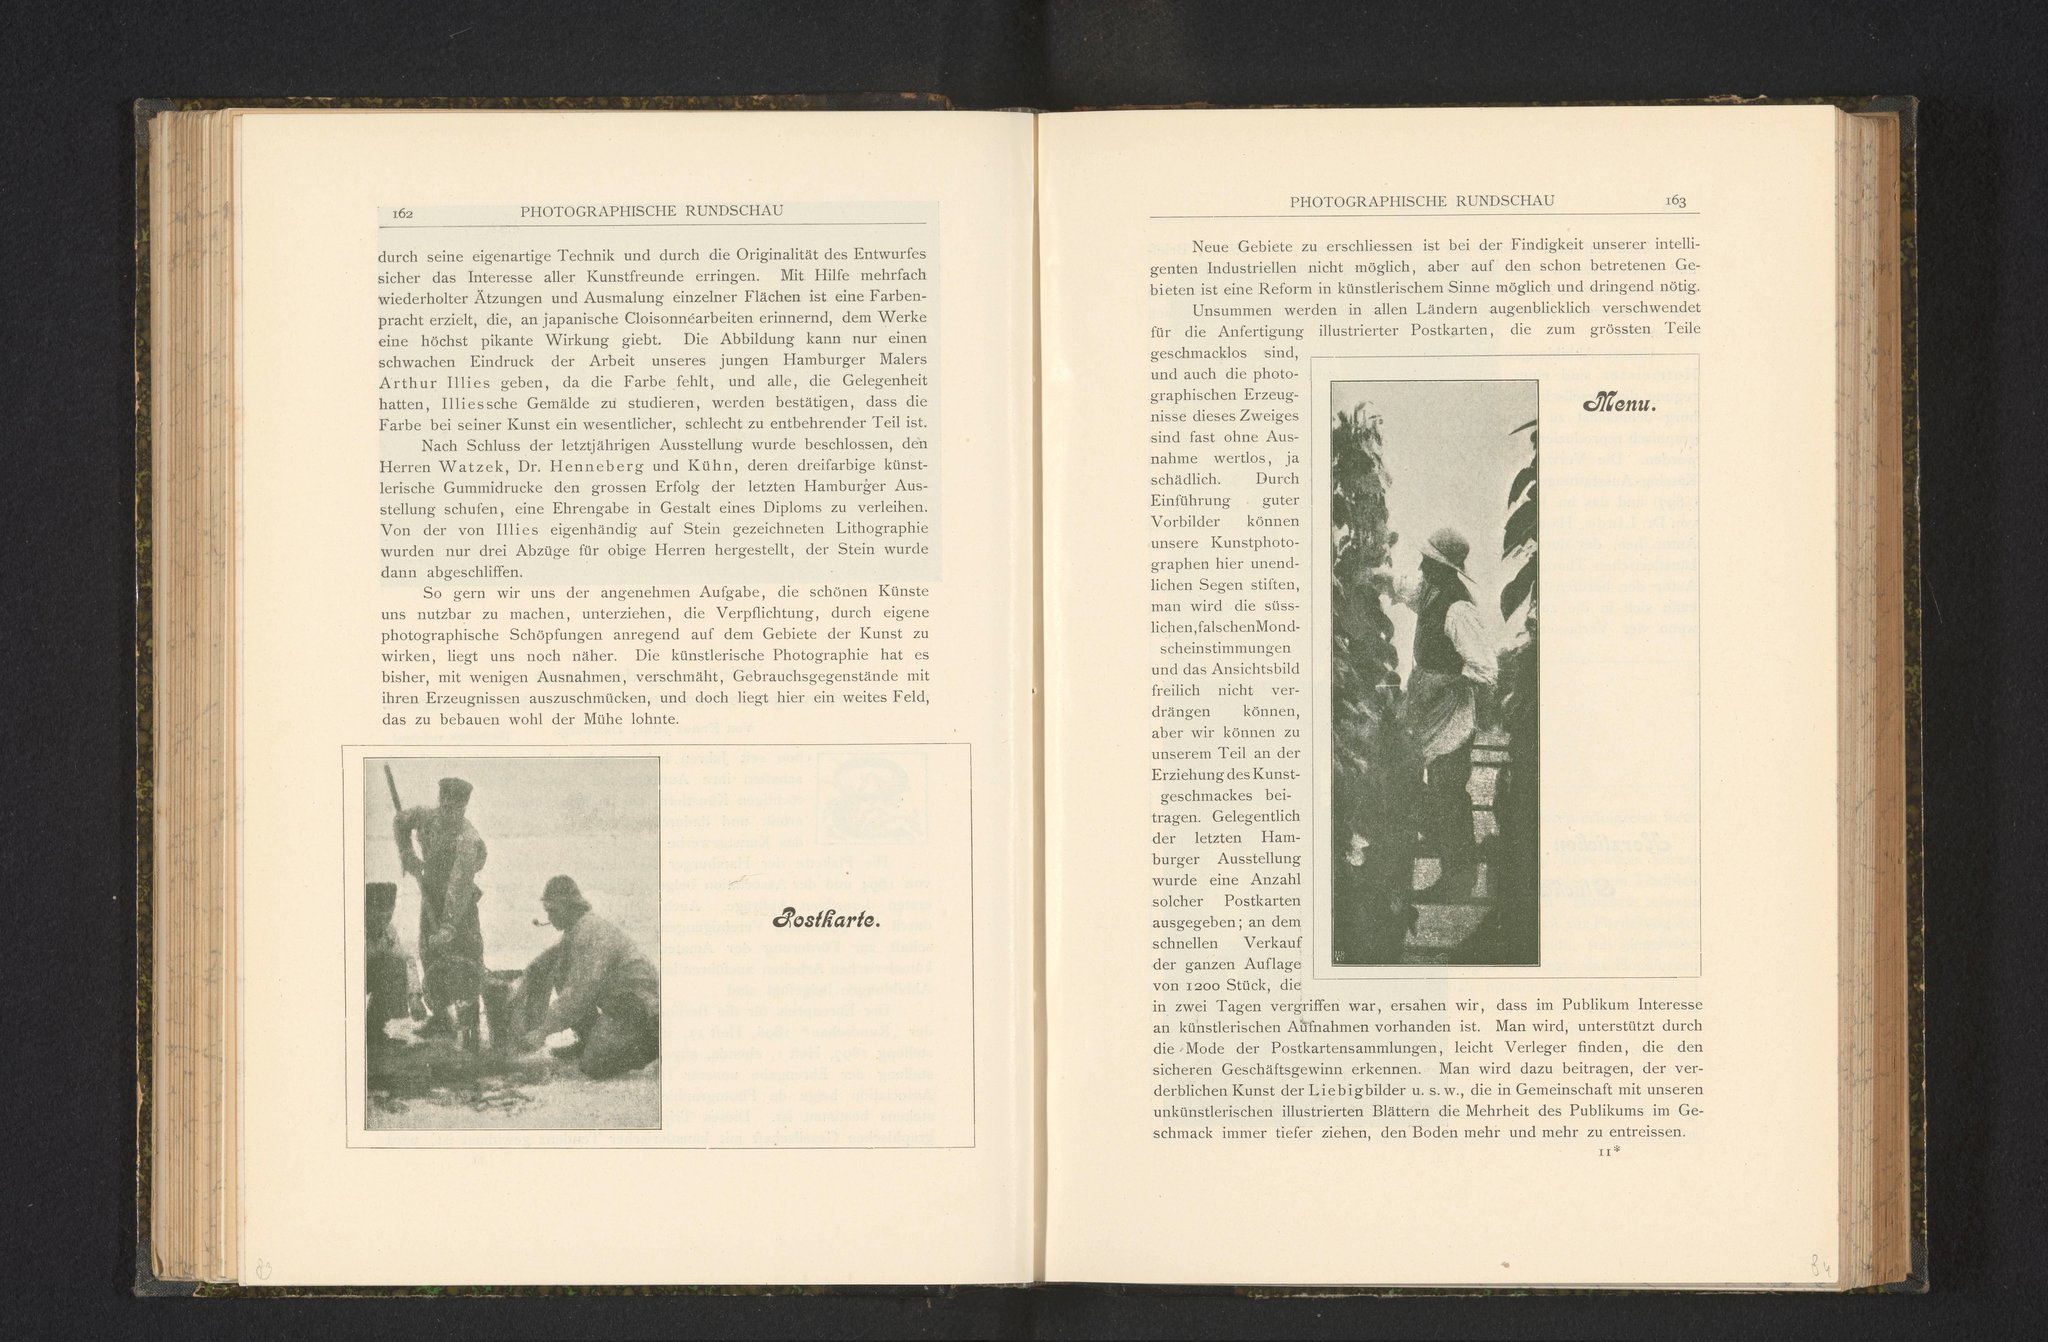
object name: page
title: Man naast een struik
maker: Anonymous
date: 1893-1898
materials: paper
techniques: autotype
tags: shrubs, adult man